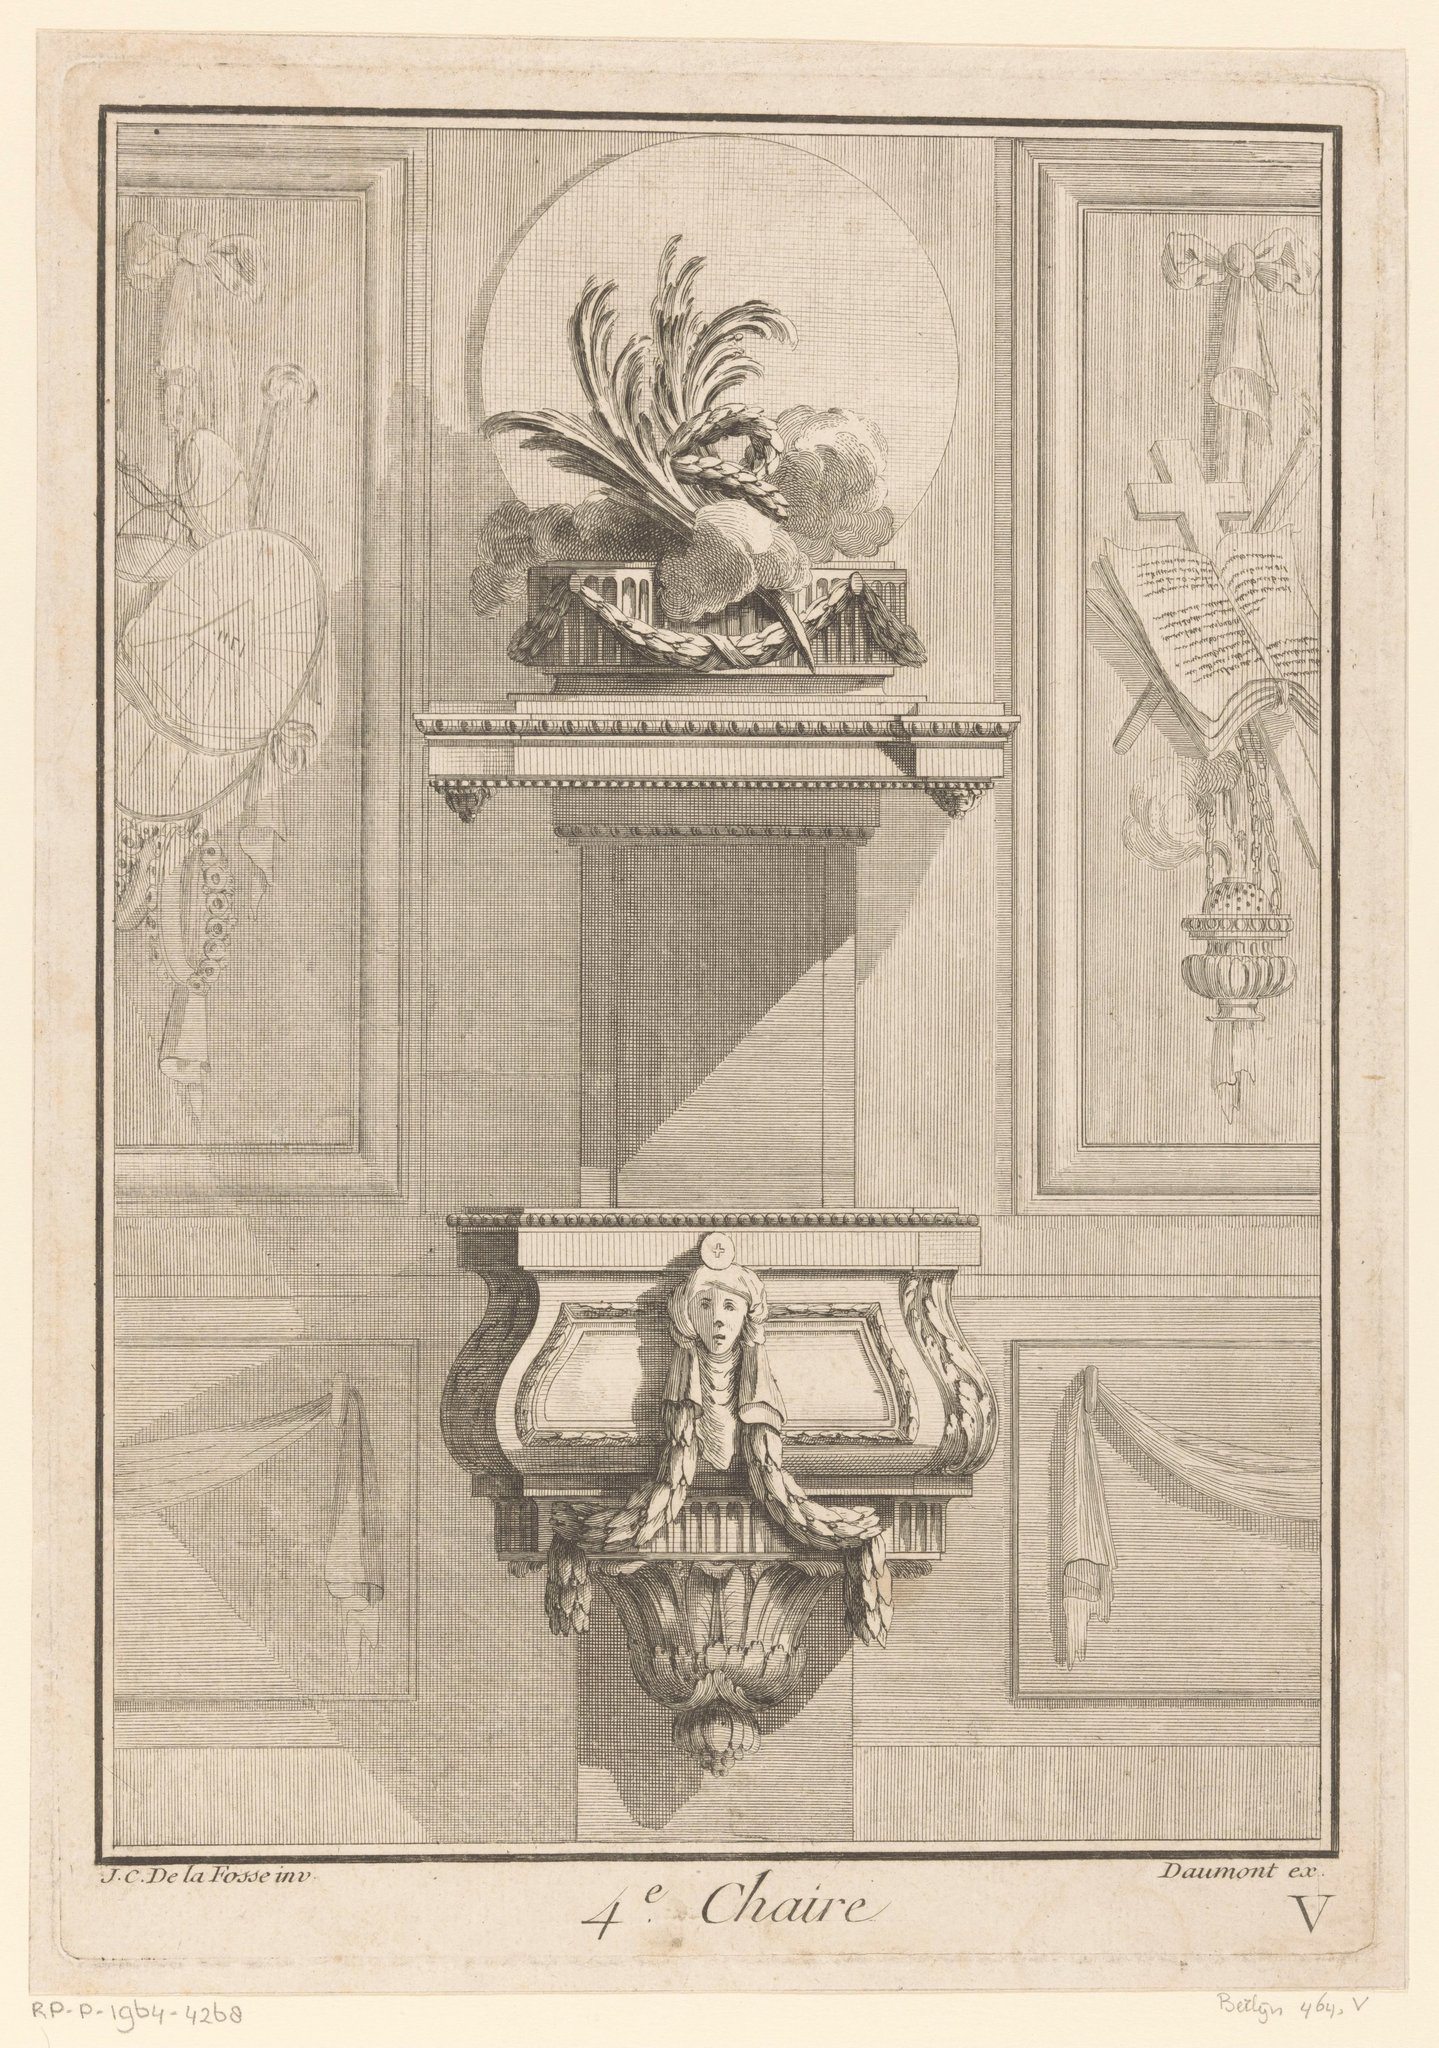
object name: ornament print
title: 4e Chaire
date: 1745-1755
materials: paper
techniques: engraving, etching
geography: paris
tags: garland, wreath, pulpit, ambo, chancel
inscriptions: collector's mark: Lugt 2760, collector's mark: Lugt 2228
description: Een preekstoel met een masker en guirlandes. Op de bekroning lauwerkransen en takken omgeven door wolken. Links en rechts panelen met schilderingen.